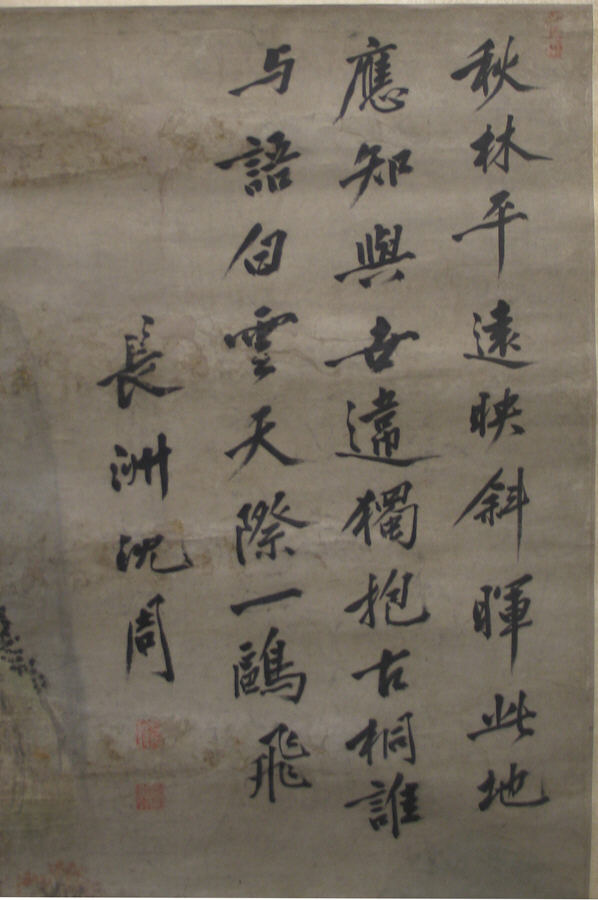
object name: hanging scroll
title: A Large Landscape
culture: chinese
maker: unidentified artist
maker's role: artist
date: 1644-1911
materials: ink, paper